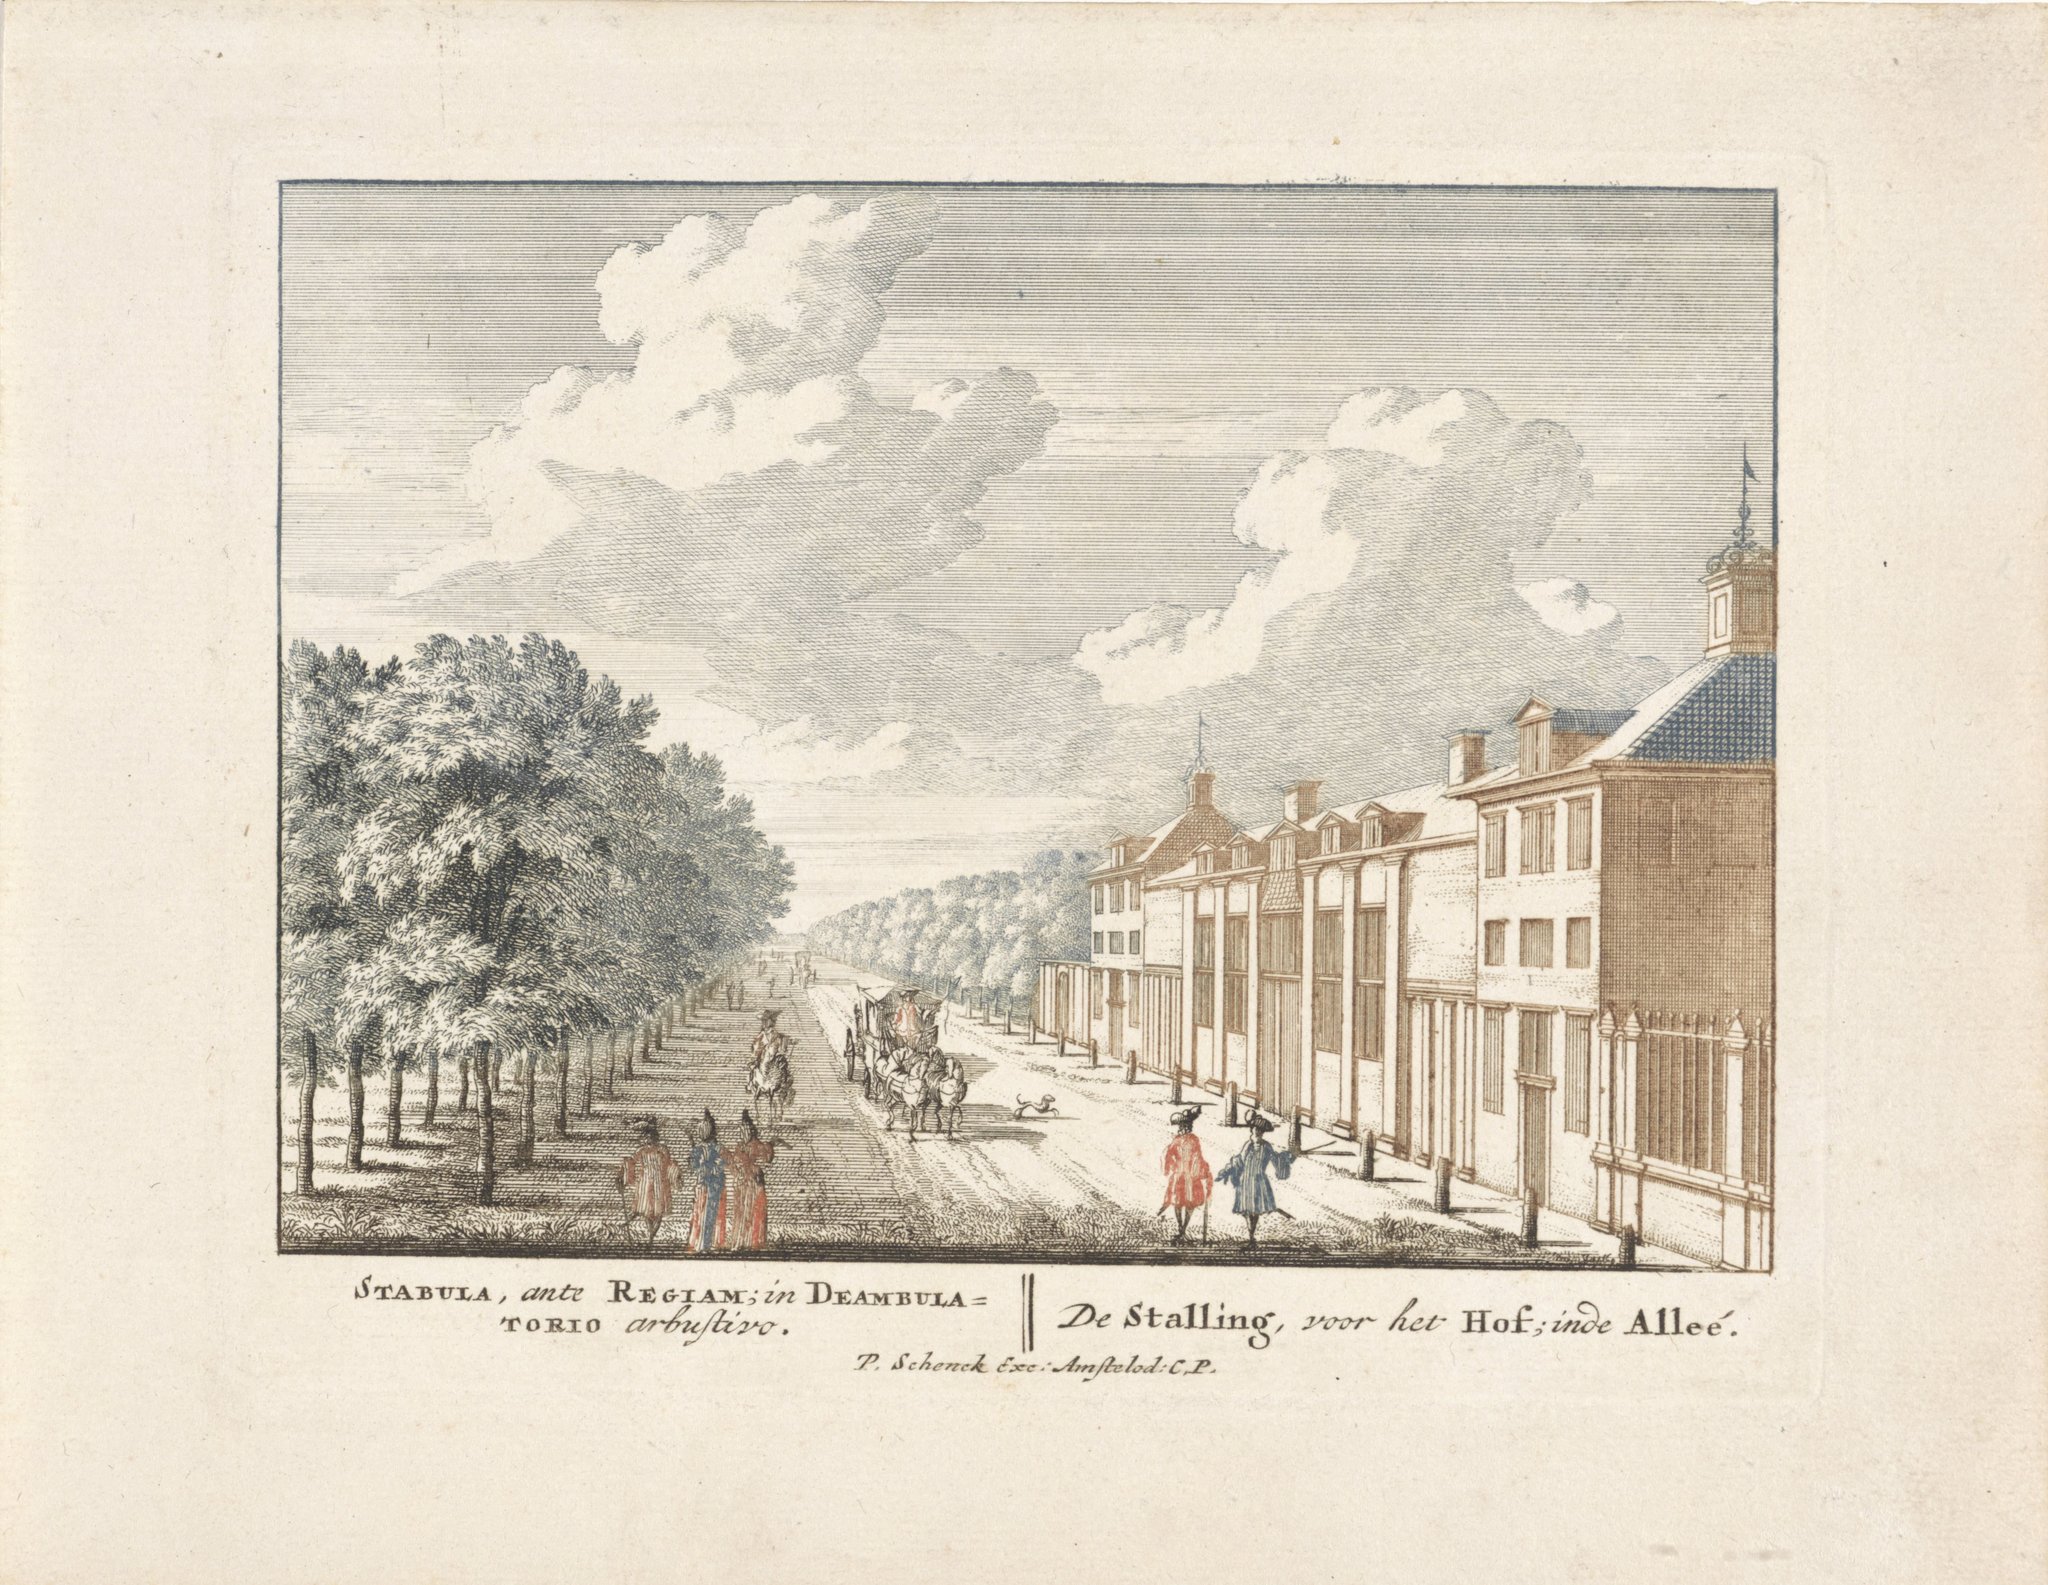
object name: print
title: Uitgeleesene Gesichte van het Wijdvermaarde Loo als andere vorstelijke Huisen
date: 1694-1697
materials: paper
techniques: etching, hand coloring, lithography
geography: amsterdam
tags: french or architectonic garden; formal garden, 'jeu de boules', stall, stable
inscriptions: collector's mark: Lugt 2228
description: Prent uit een serie van 71 prenten met Rijnlandschappen, gezichten op vorstelijke paleizen en stadsgezichten uit Den Haag en Amsterdam.